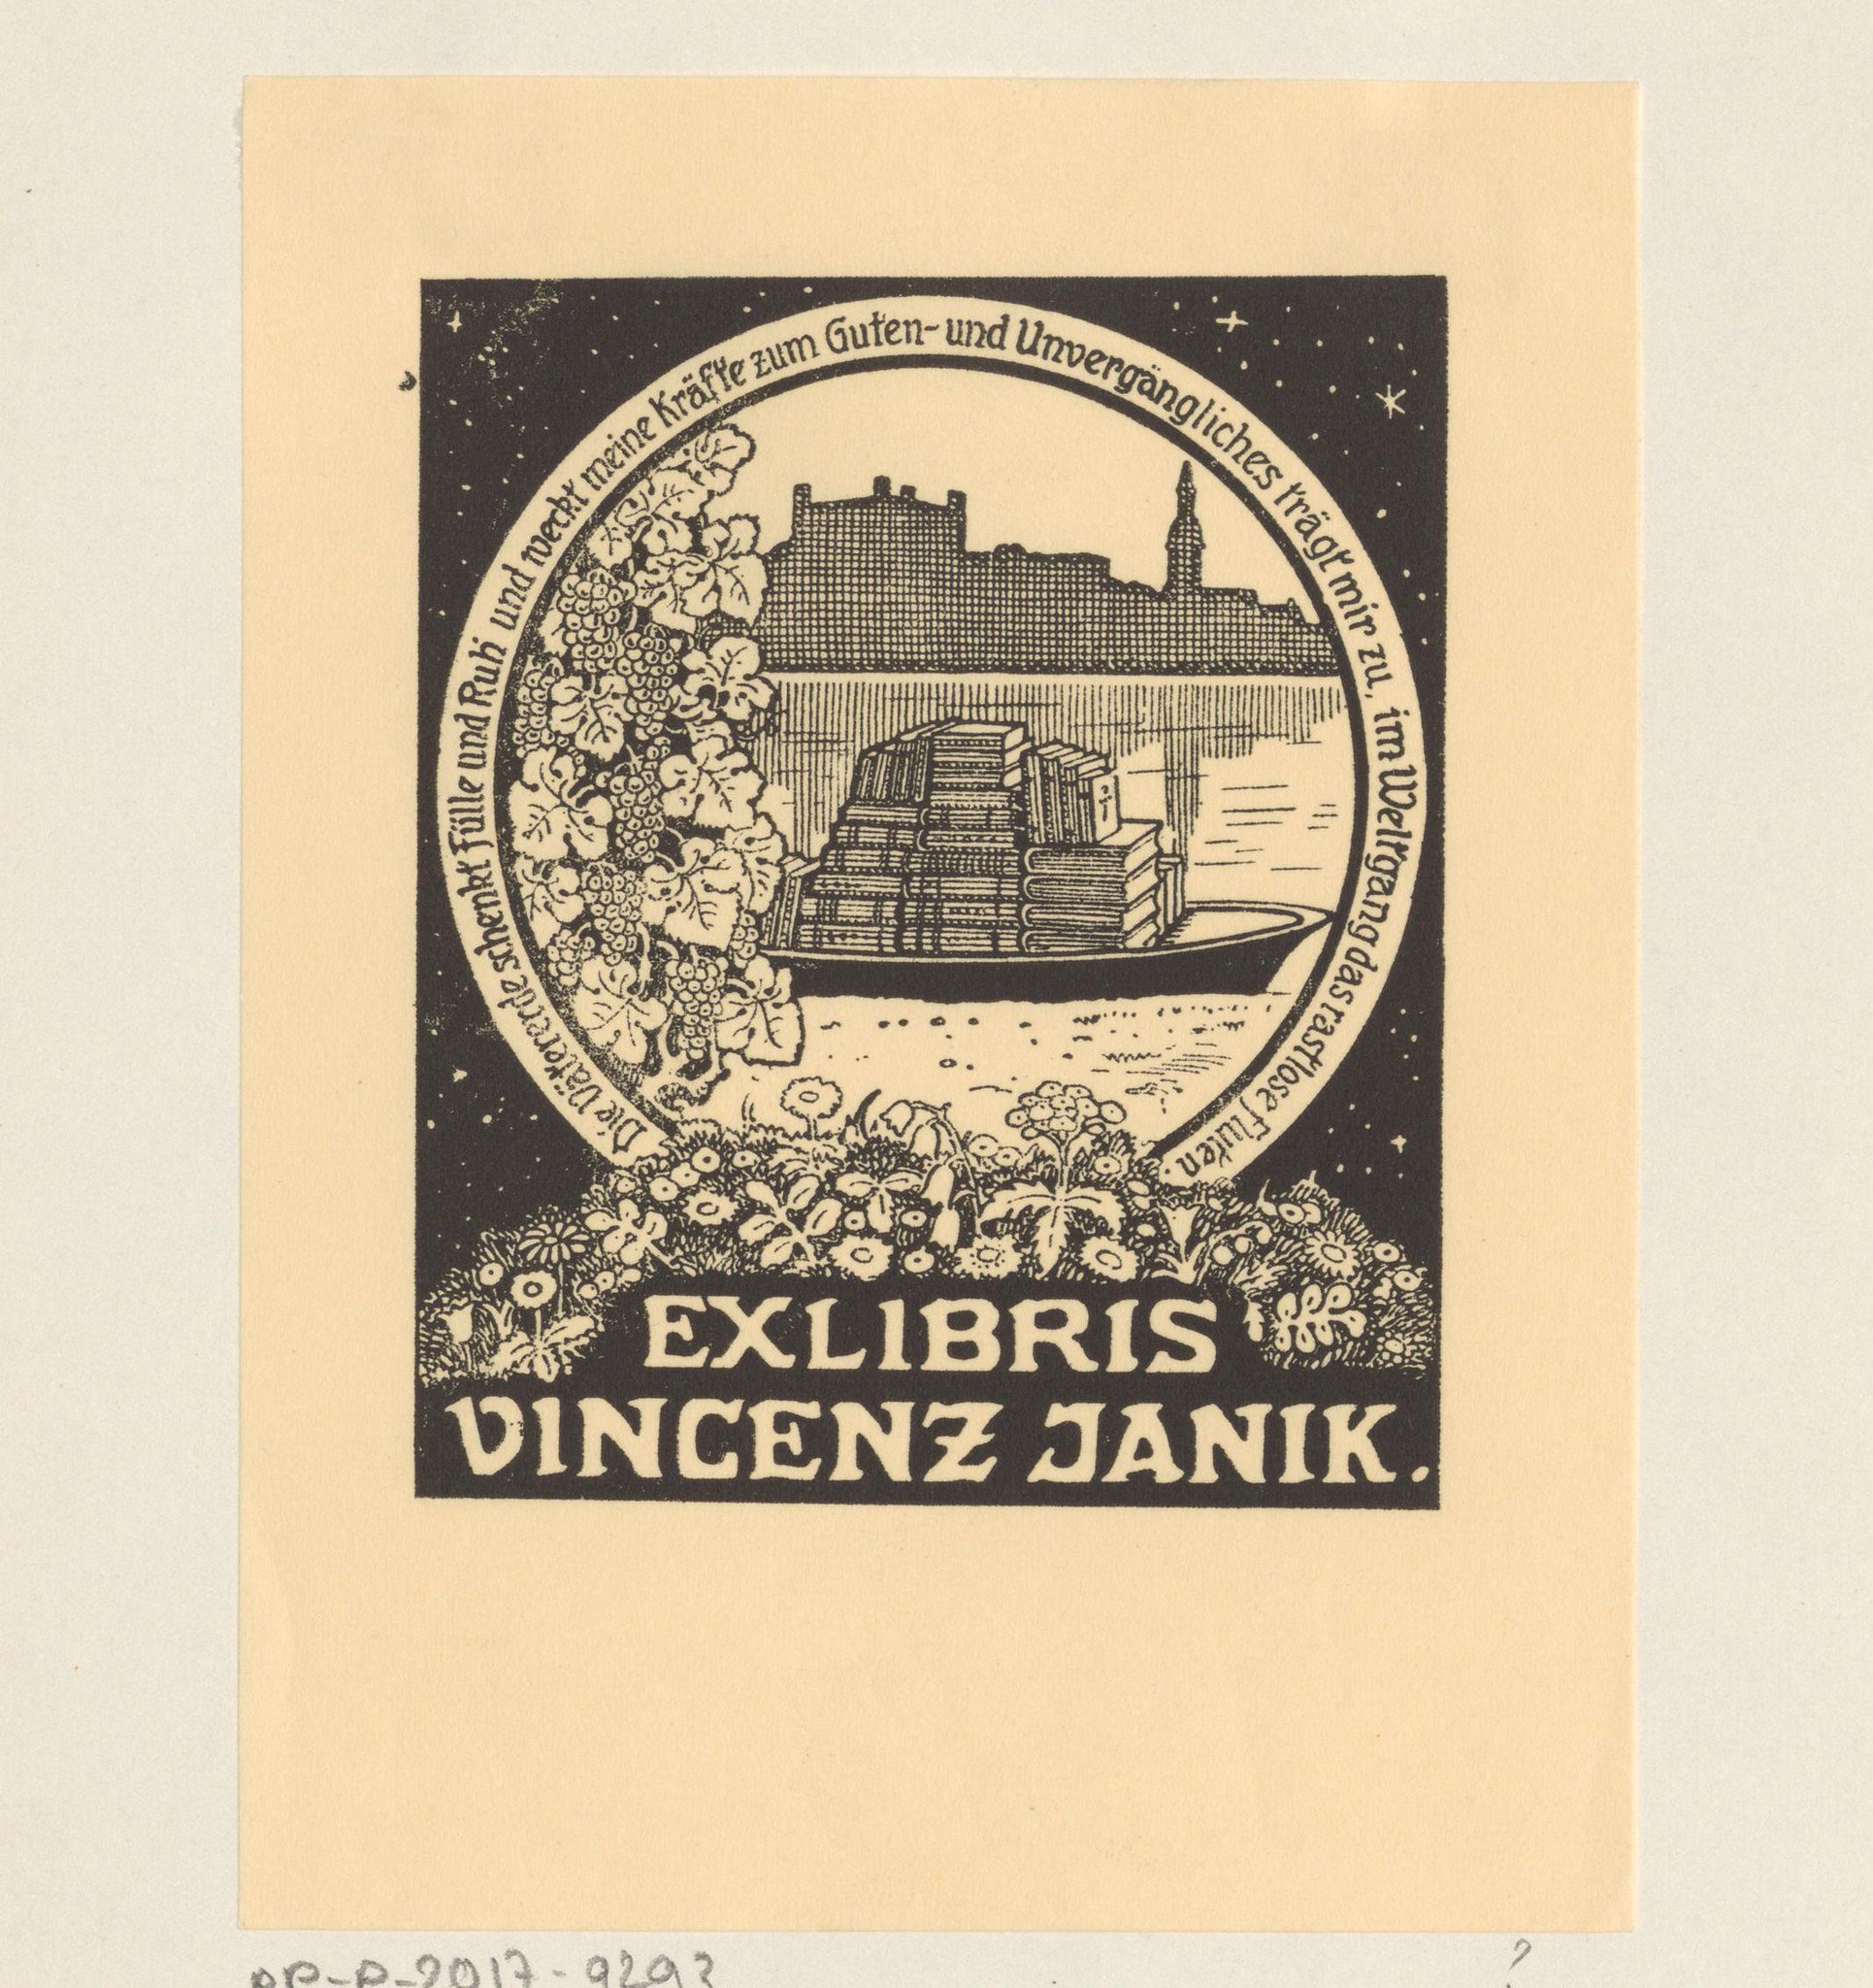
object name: bookplate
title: Ex libris van Vincenz Janik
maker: Anonymous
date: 1893-1945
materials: paper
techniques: printing block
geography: czech republic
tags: vine, flowers, book, prospect of city, town panorama, silhouette of city, boat propelled by man or animal